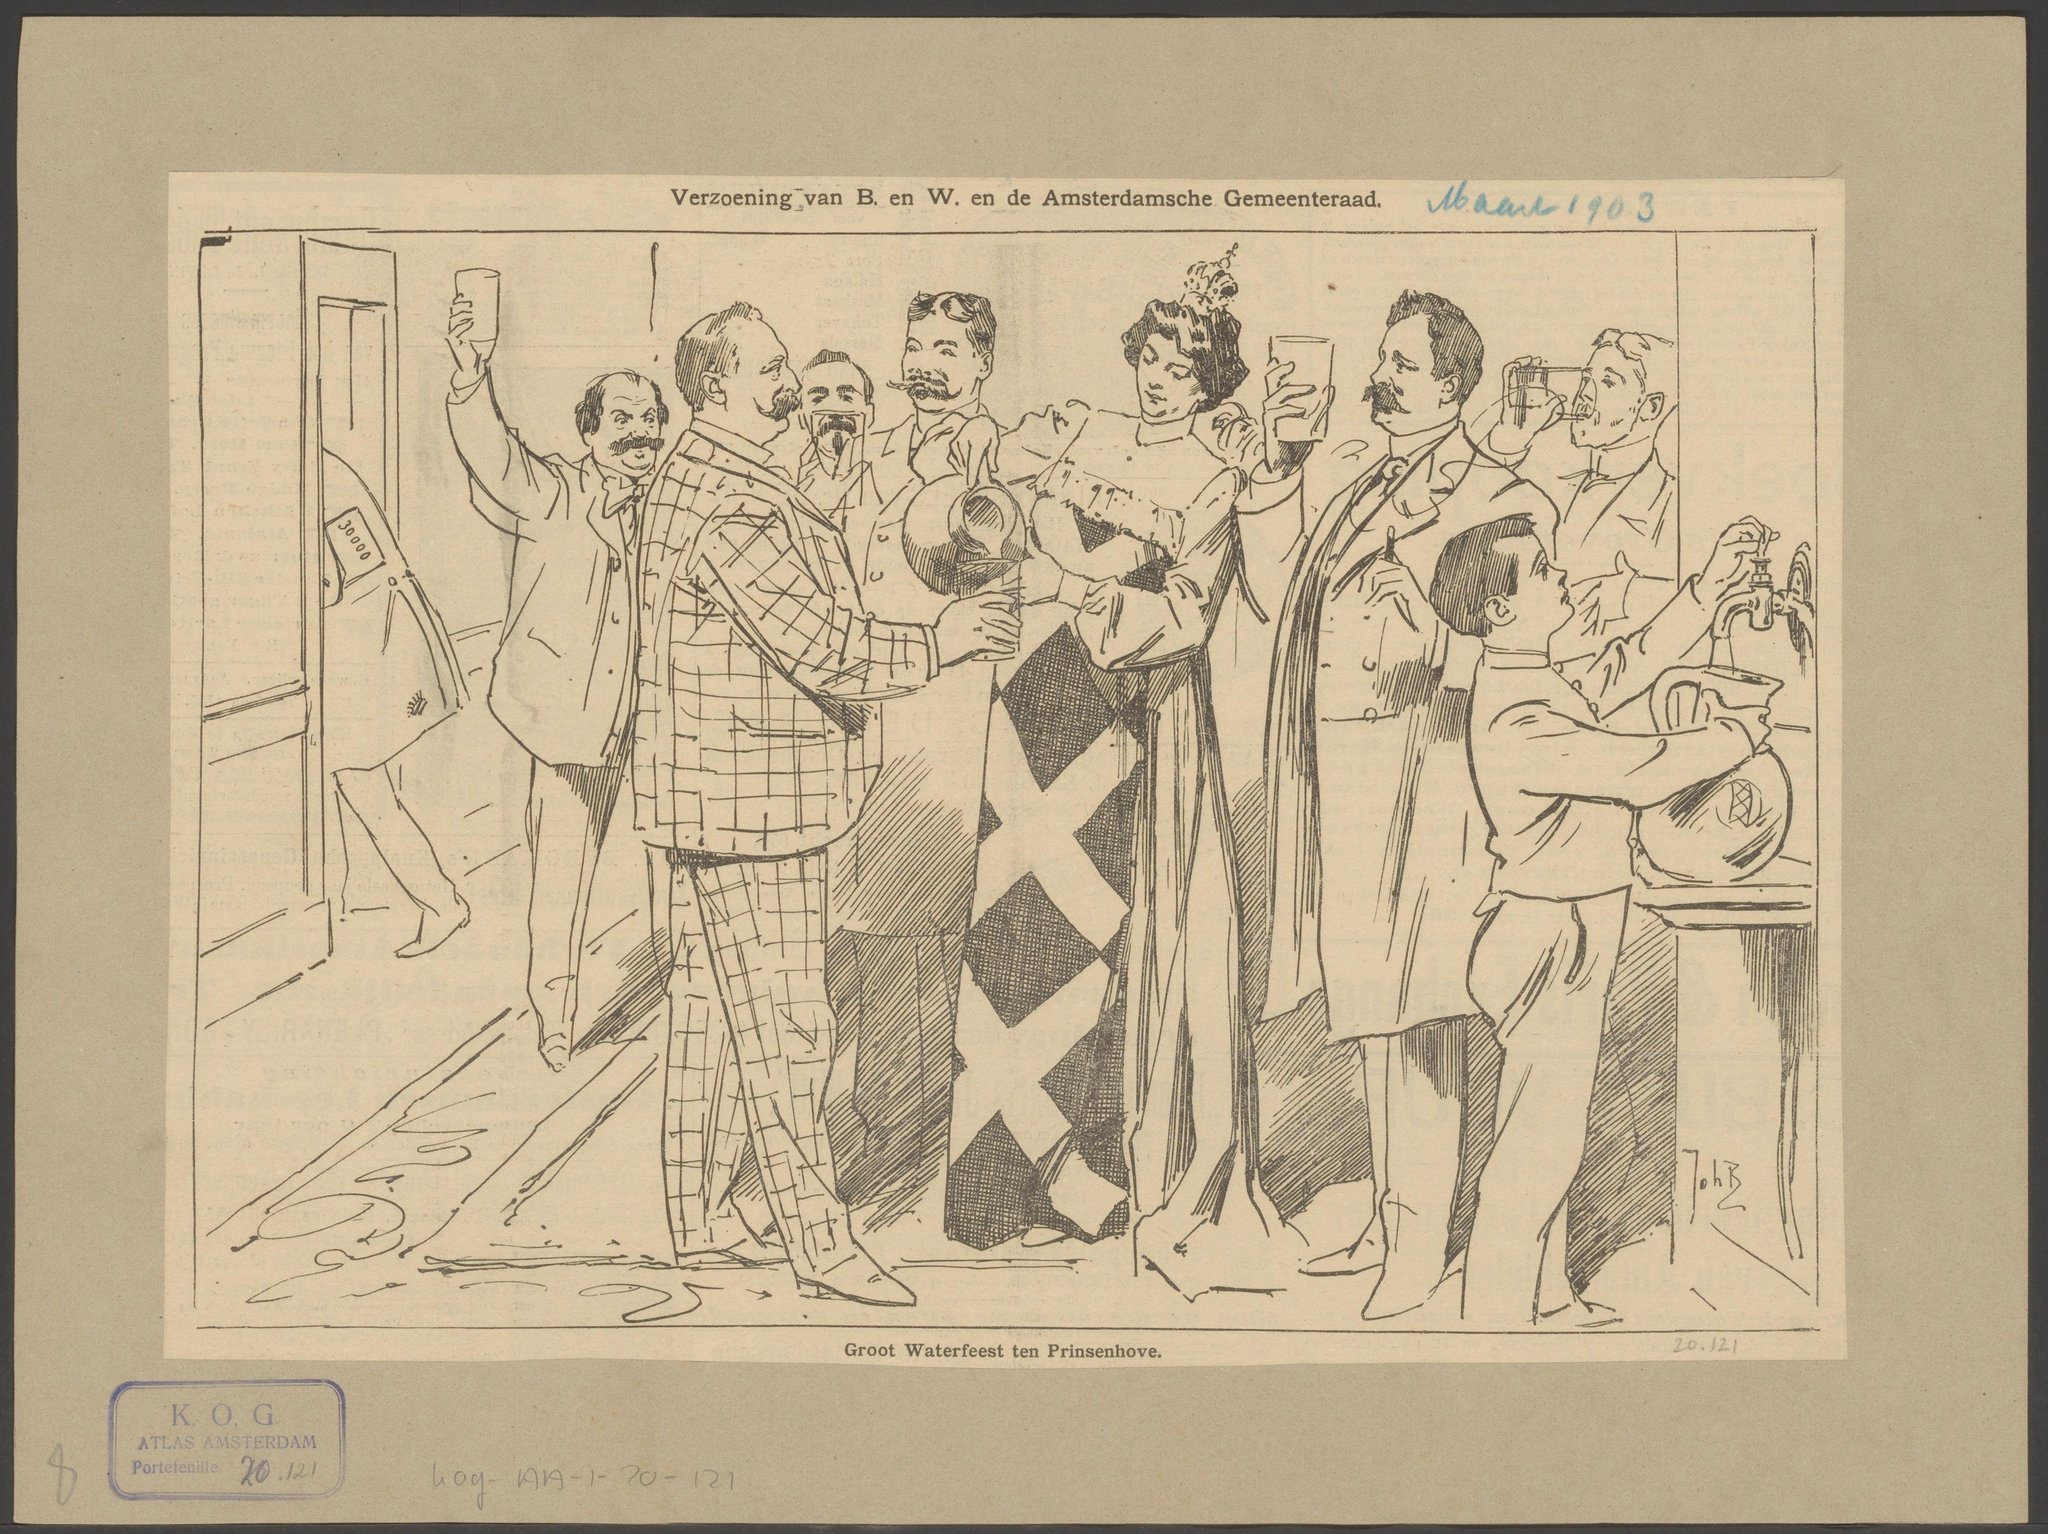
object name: photomechanical print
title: Verzoening van B. en W. en de Amsterdamsche Gemeenteraad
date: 1903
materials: paper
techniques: letterpress printing, line block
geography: netherlands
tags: personification of a city, town-patron(ess), reception, cocktail party, politician, e.g. party leader, political caricatures and satires, amsterdam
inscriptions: collector's mark: Lugt 1641b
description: Onderwerpsrubriek binnen de Atlas Amsterdam: Verkiezingen Gemeenteraad.